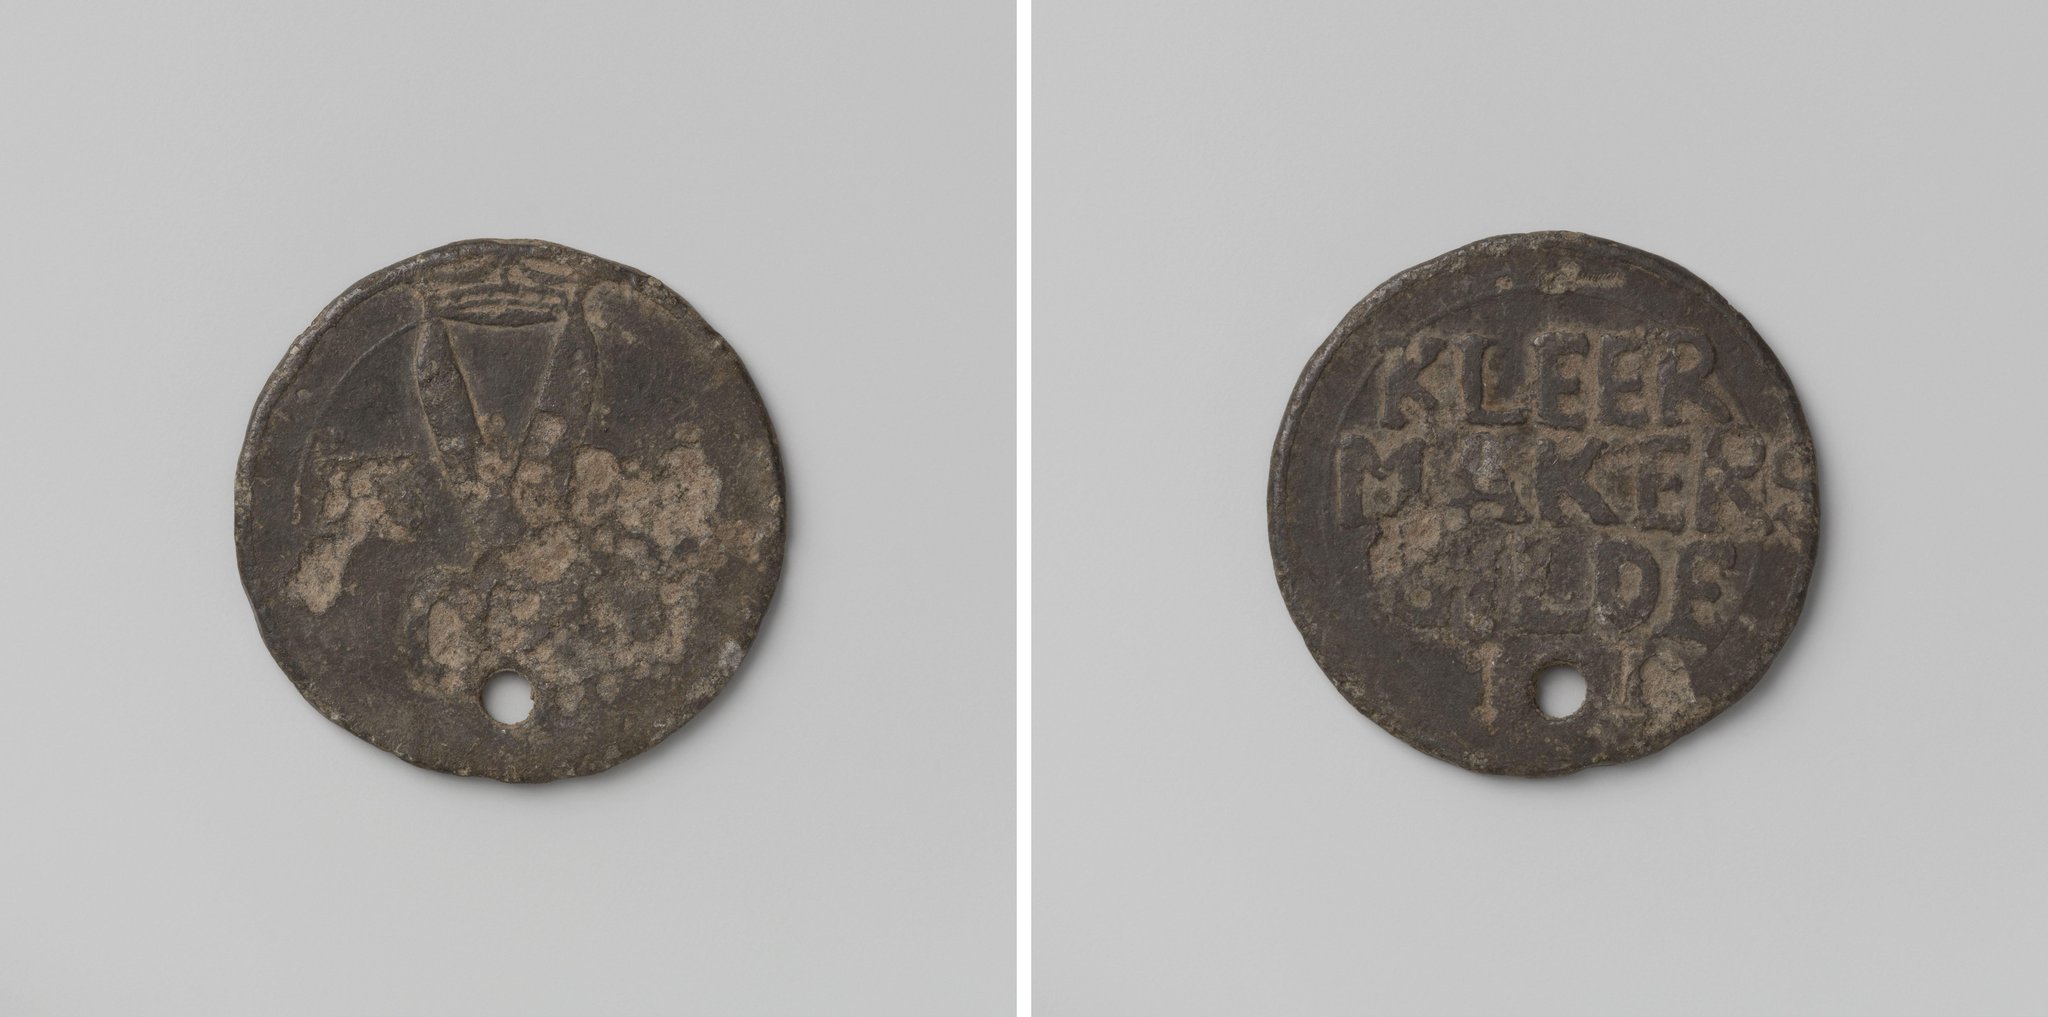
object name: medal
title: Kleermakersgilde van Gent, gildepenning met no. 17 of 11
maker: Anonymous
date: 1400-1885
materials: lead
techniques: casting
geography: goes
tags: ghent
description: Loden penning met gat erin. Voorzijde: gekroonde schaar tussen jaartal. Keerzijde: opschrift